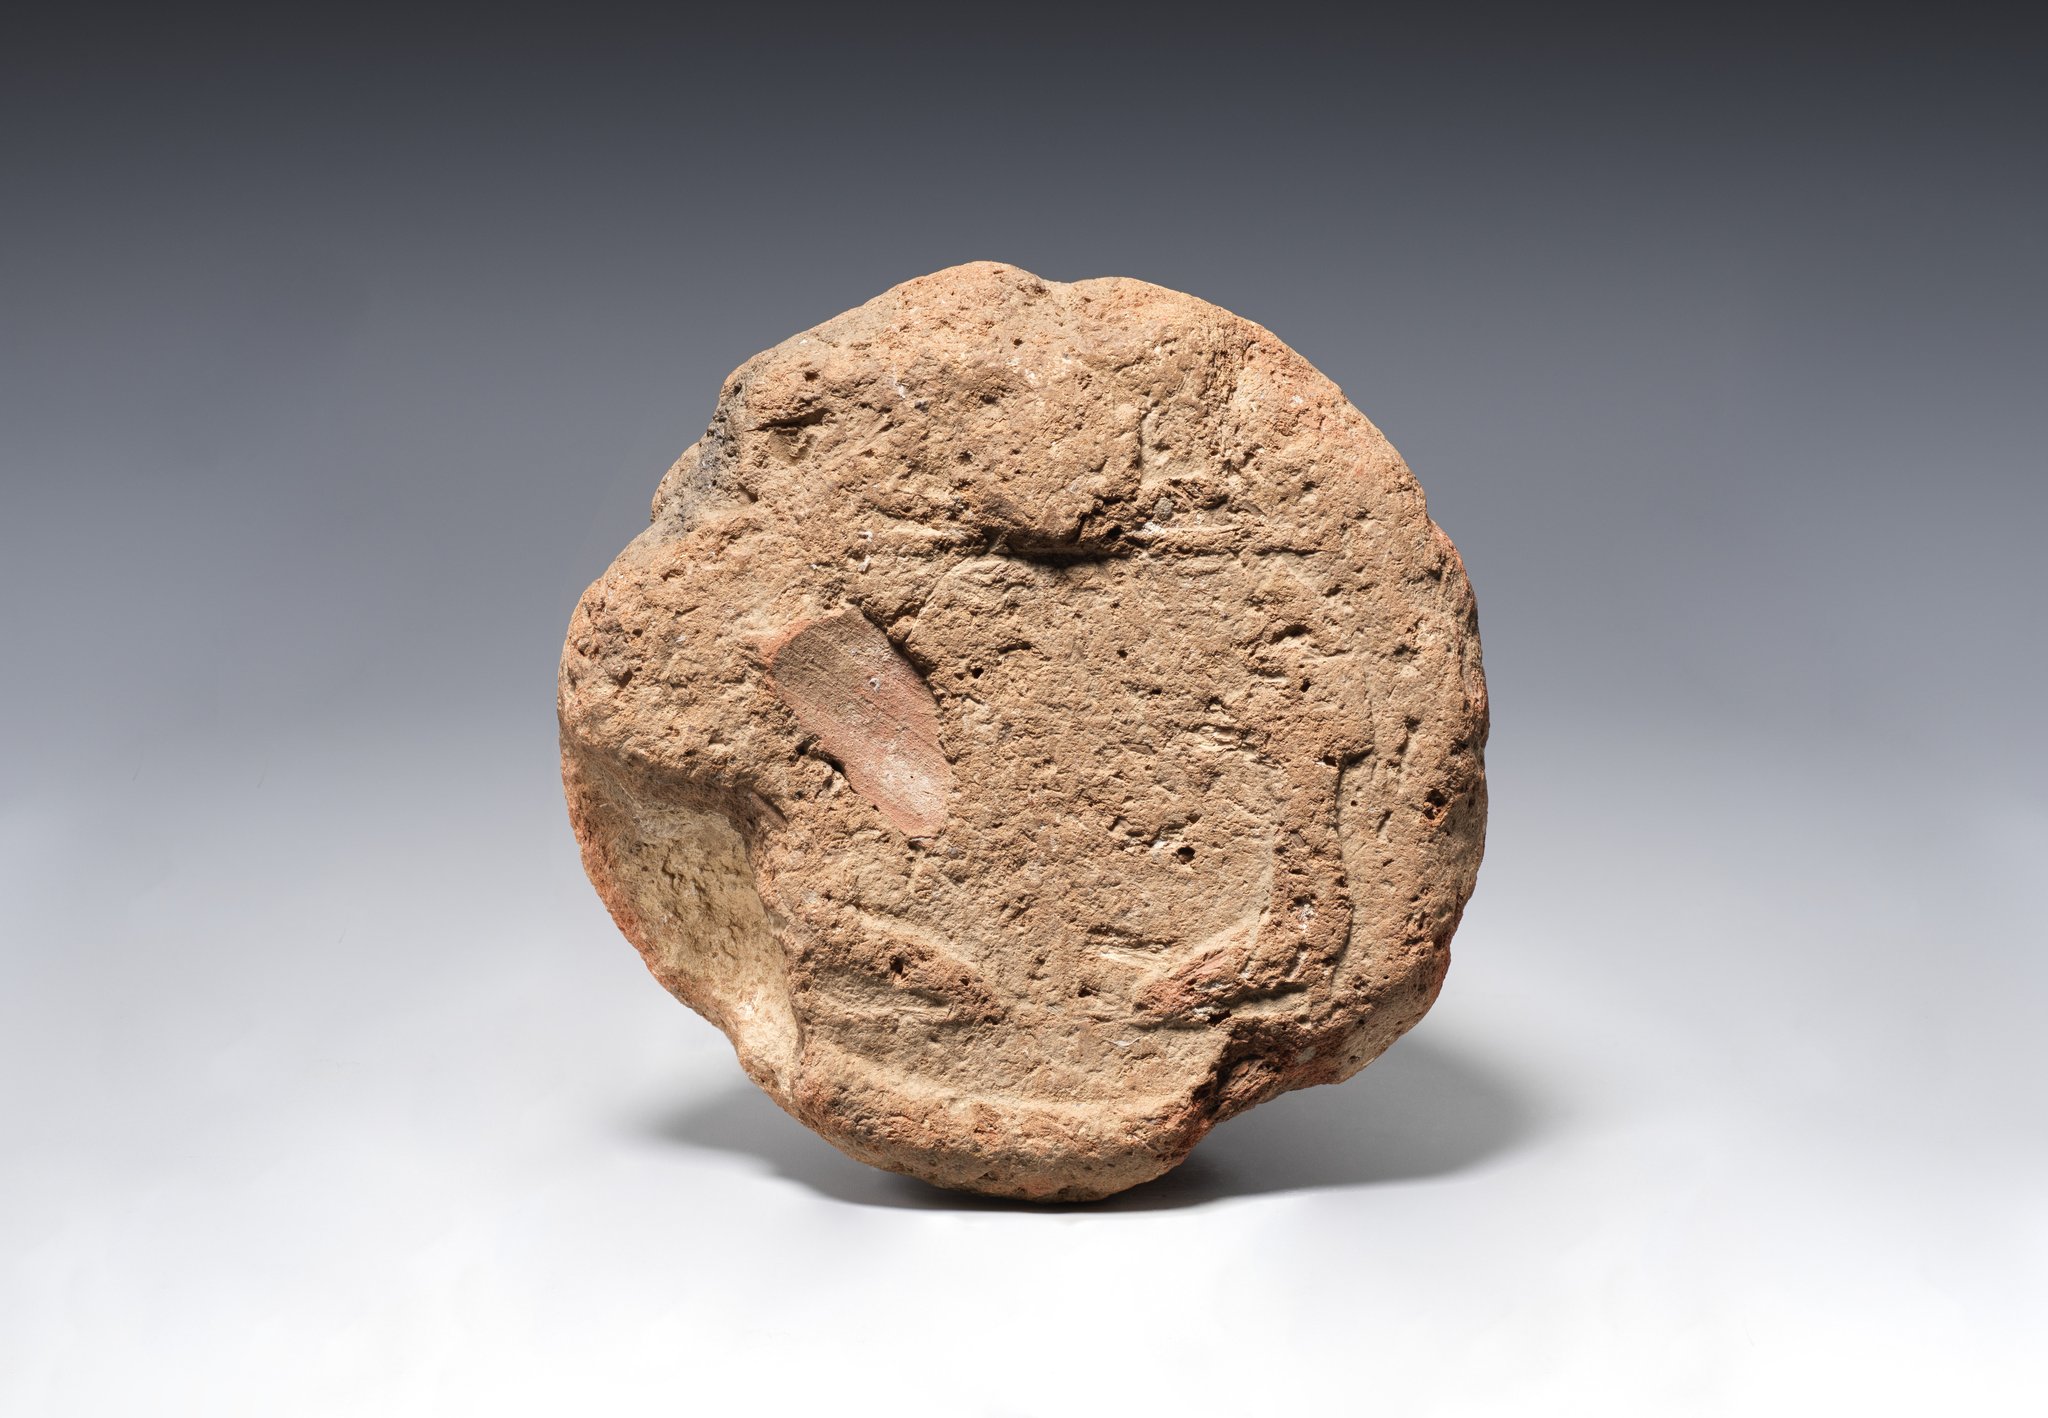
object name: cone, circular, mutirdis, divine adoratrice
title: Funerary Cone of Mutirdis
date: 712-525 BCE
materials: pottery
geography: egypt